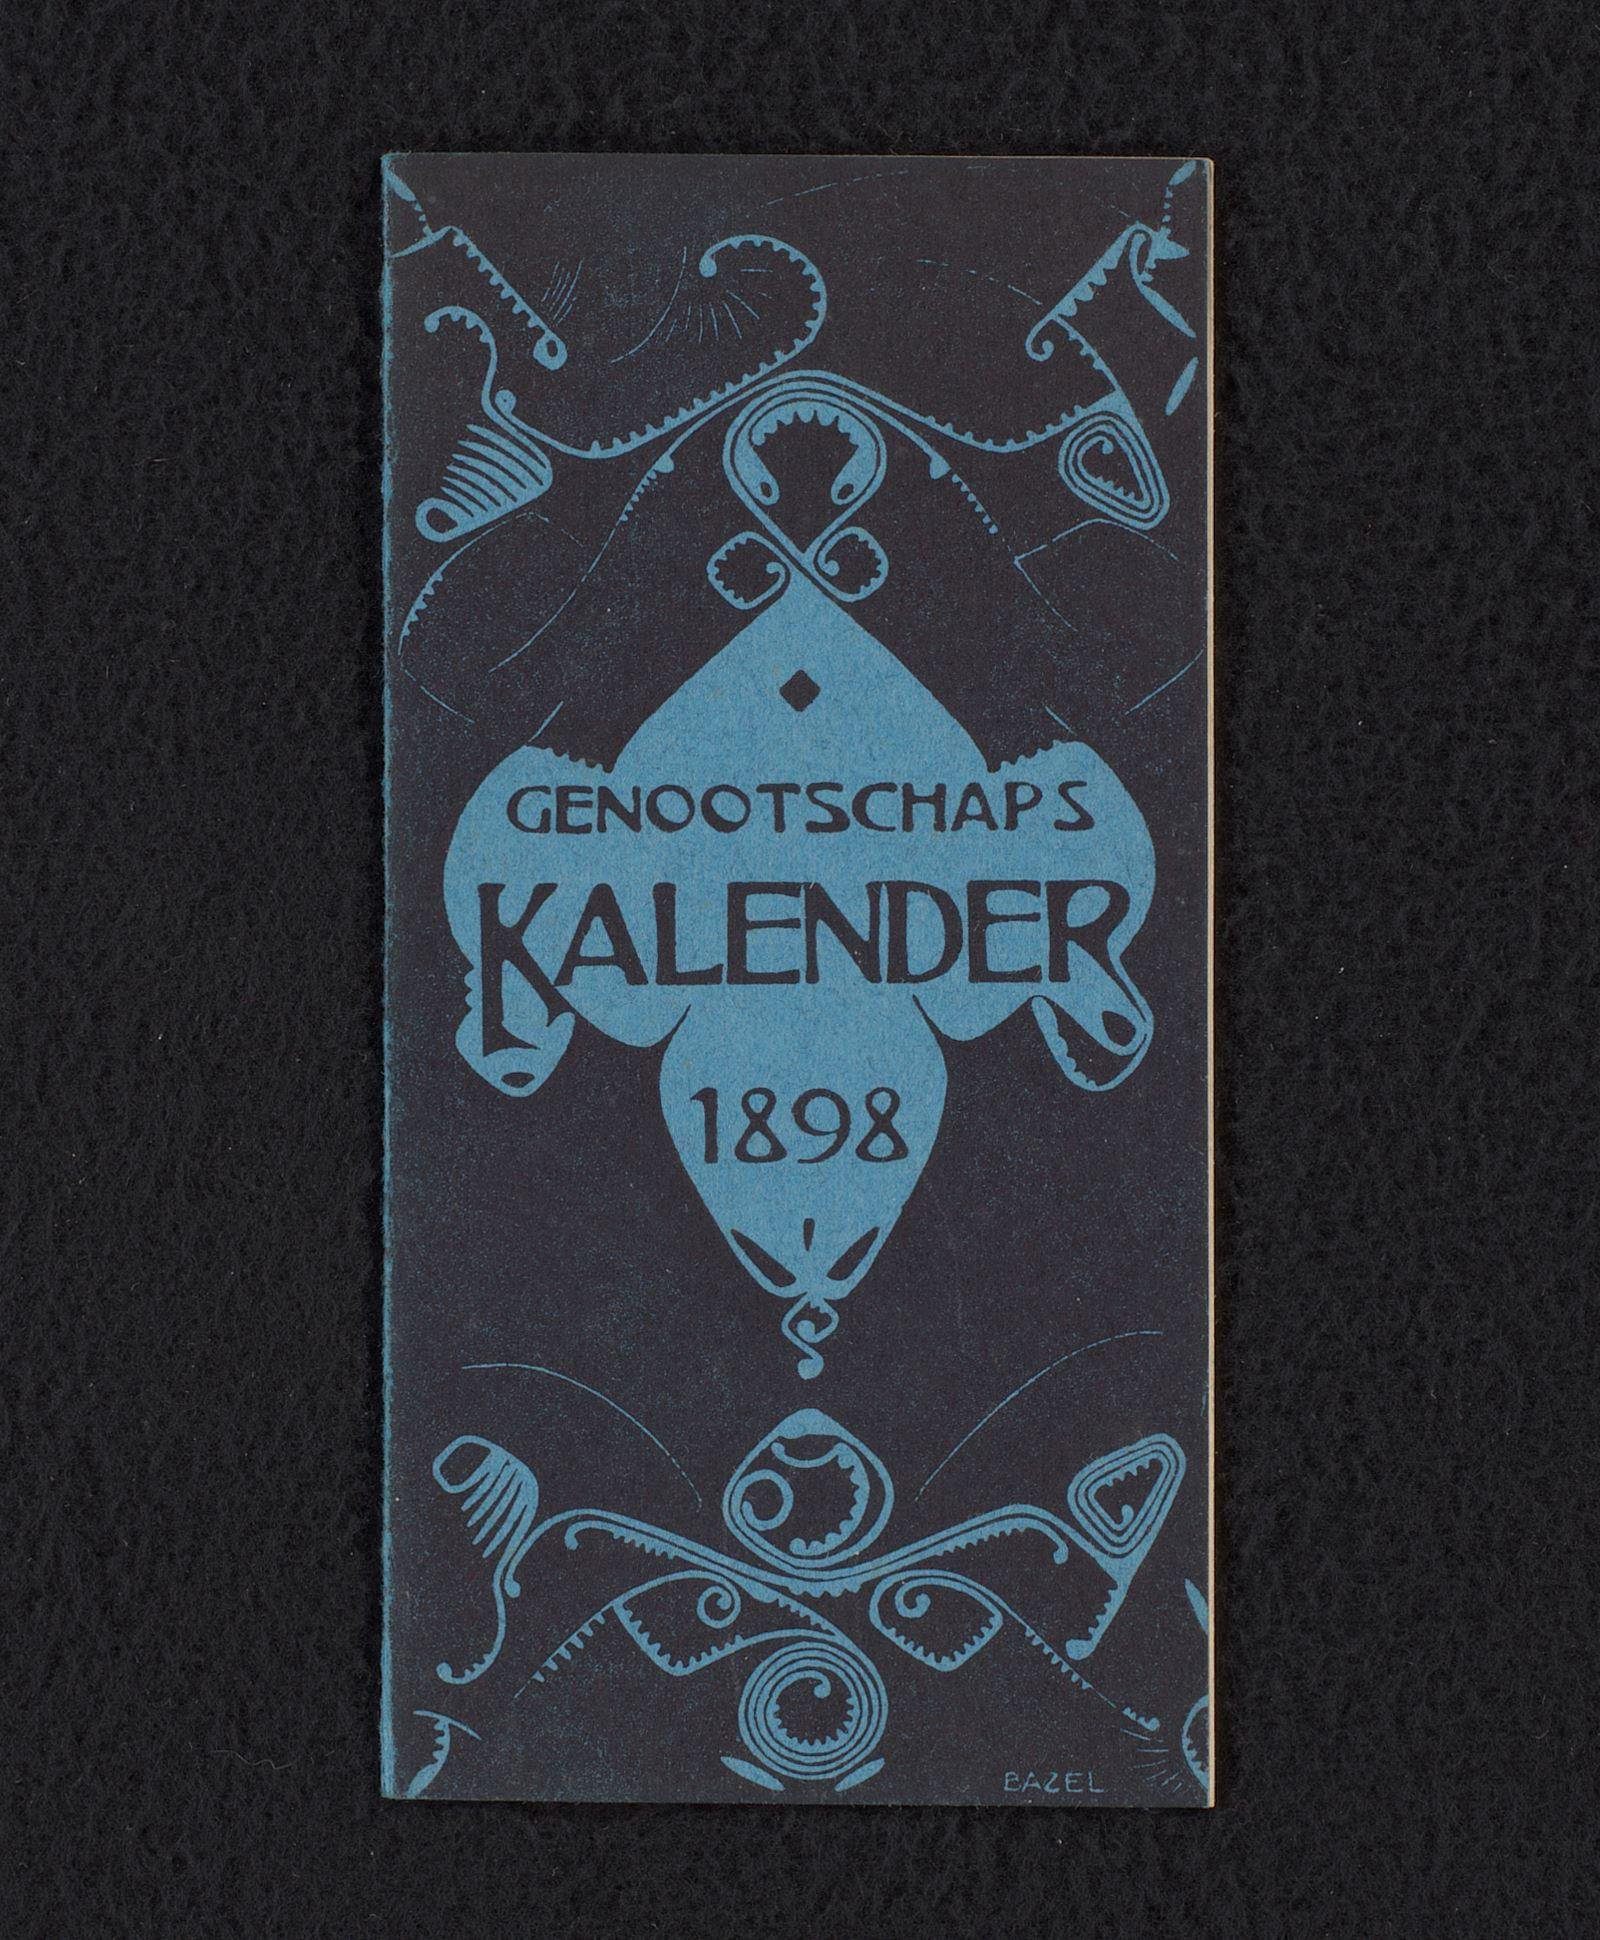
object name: calendar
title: Genootschaps Kalender 1898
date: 1897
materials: paper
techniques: bookbinding, letterpress printing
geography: amsterdam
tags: ornaments ~ art, calendar, almanac, amsterdam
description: Klein boekje van 24 bladzijden met op iedere bladzijde een halve maand. Omslag met een decoratief ontwerp, op de achterzijde van het omslag het vignet van Arti et Amicitiae.